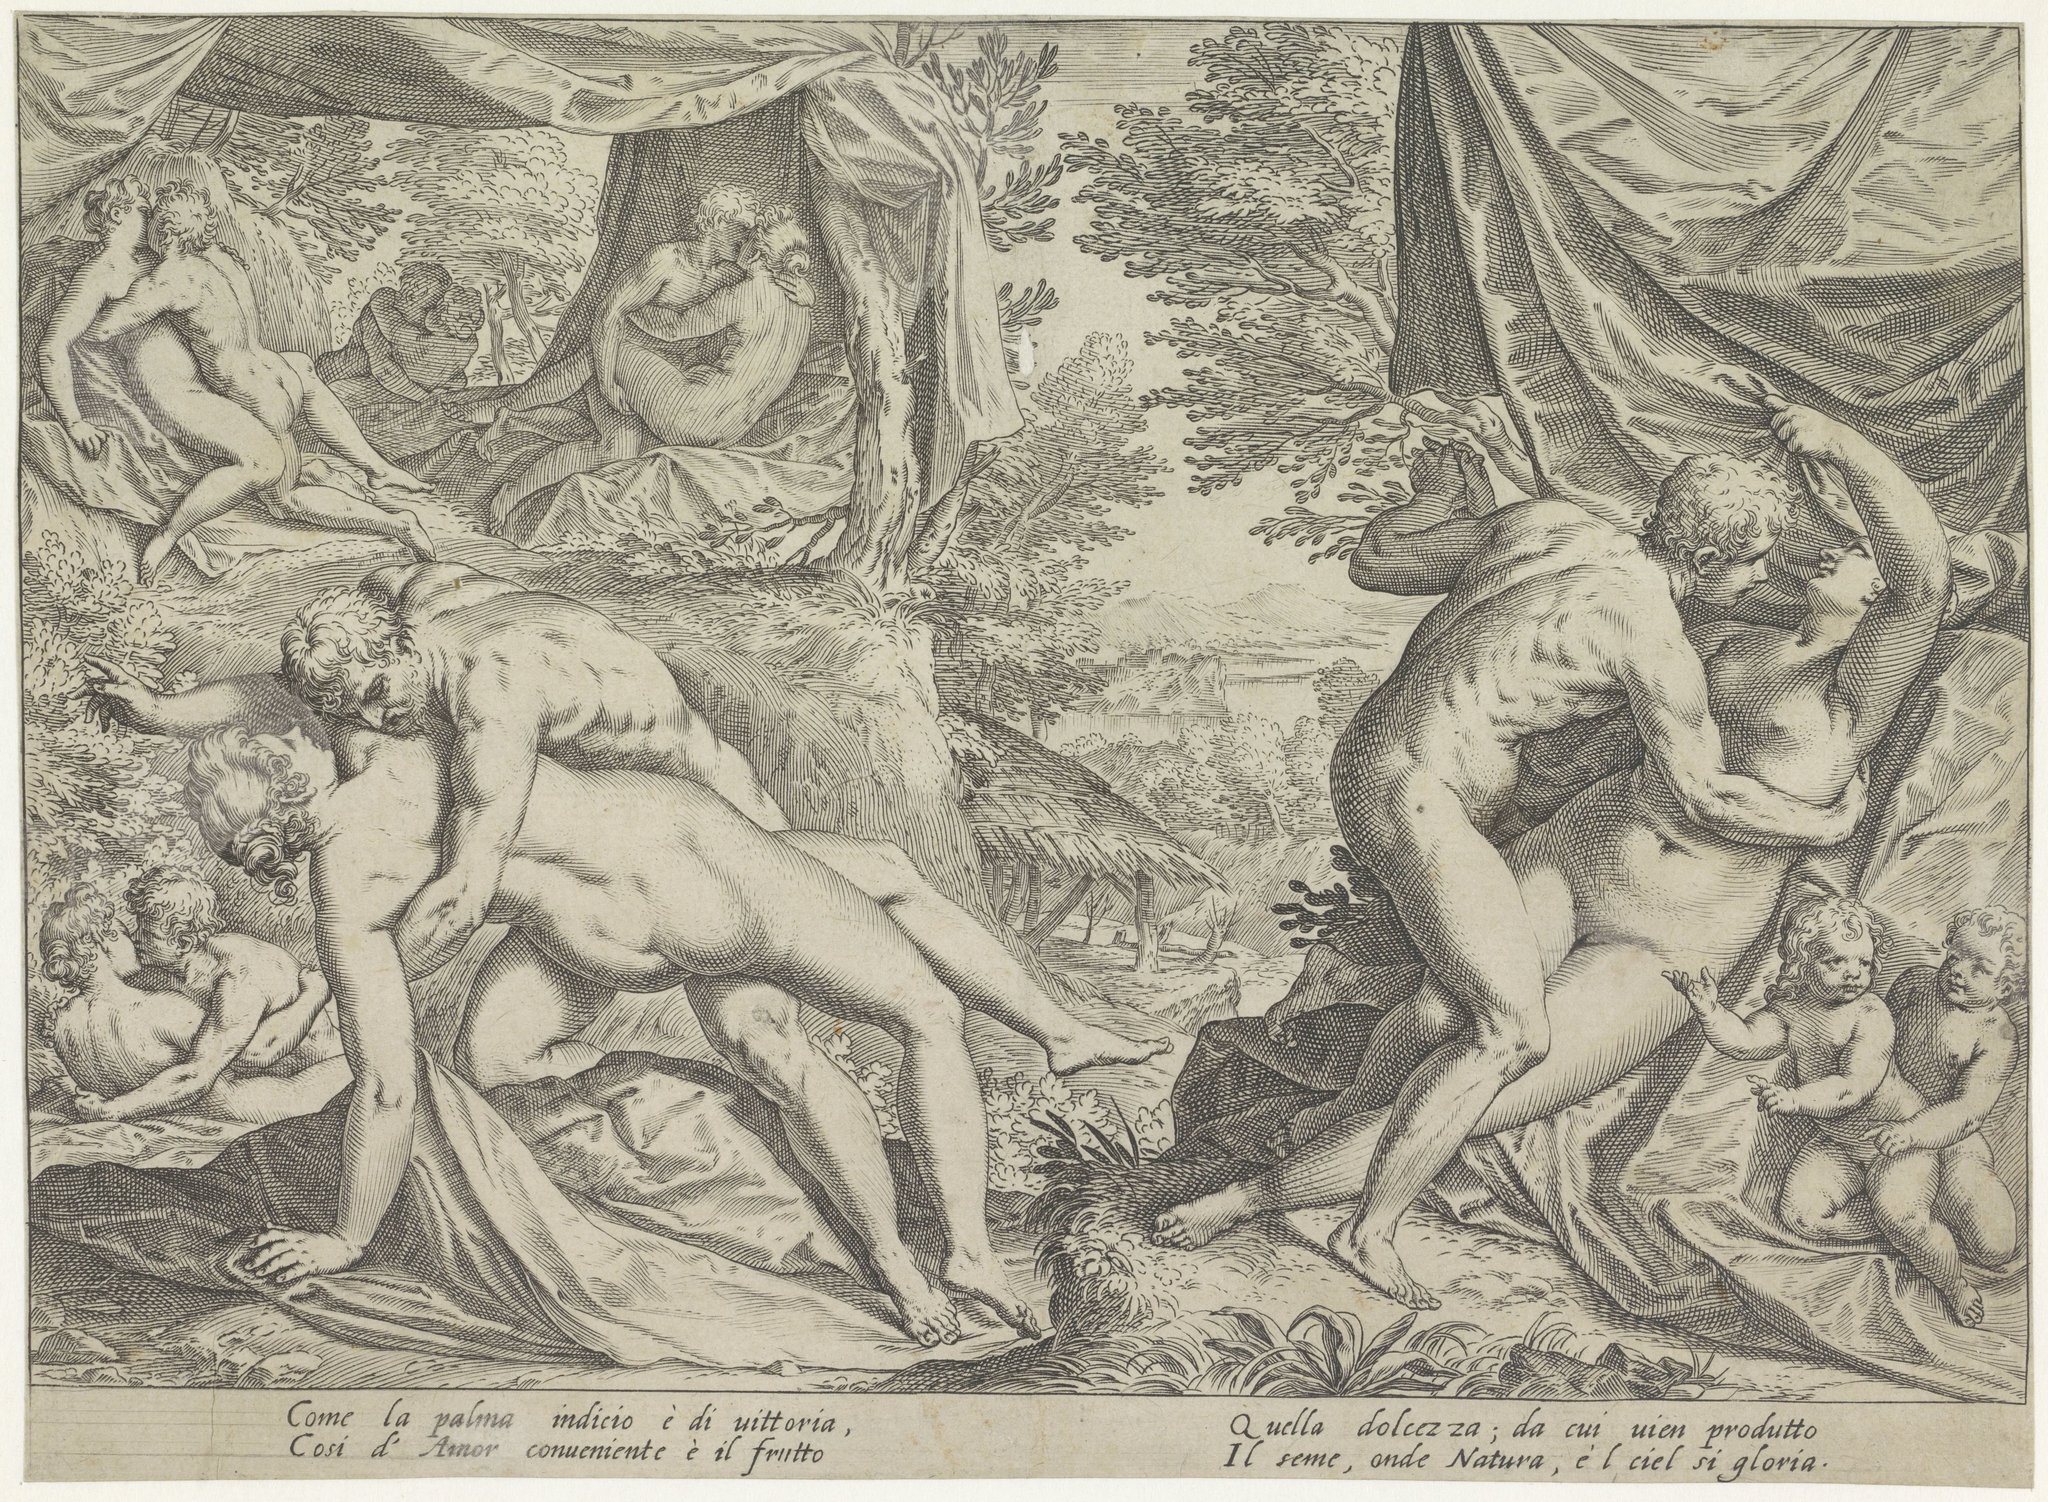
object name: print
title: Liefde in het Gouden tijdperk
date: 1589-1595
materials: paper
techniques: engraving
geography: italy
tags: the golden age, 'aetas aurea'; men live happily, gathering fruits under the reign of saturn, couple of lovers, coitus, cohabiting, sexual intercourse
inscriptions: collector's mark: Lugt 2228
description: Prent uit een serie van vier prenten waarvan twee prenten door Justus of Aegidius Sadeler zijn gemaakt en twee prenten door Agostino Carracci. De prenten zijn naar een serie van vier schilderijen die zijn toegeschreven aan Paolo Fiammingo in het Kunsthistorisches Museum te Wenen.